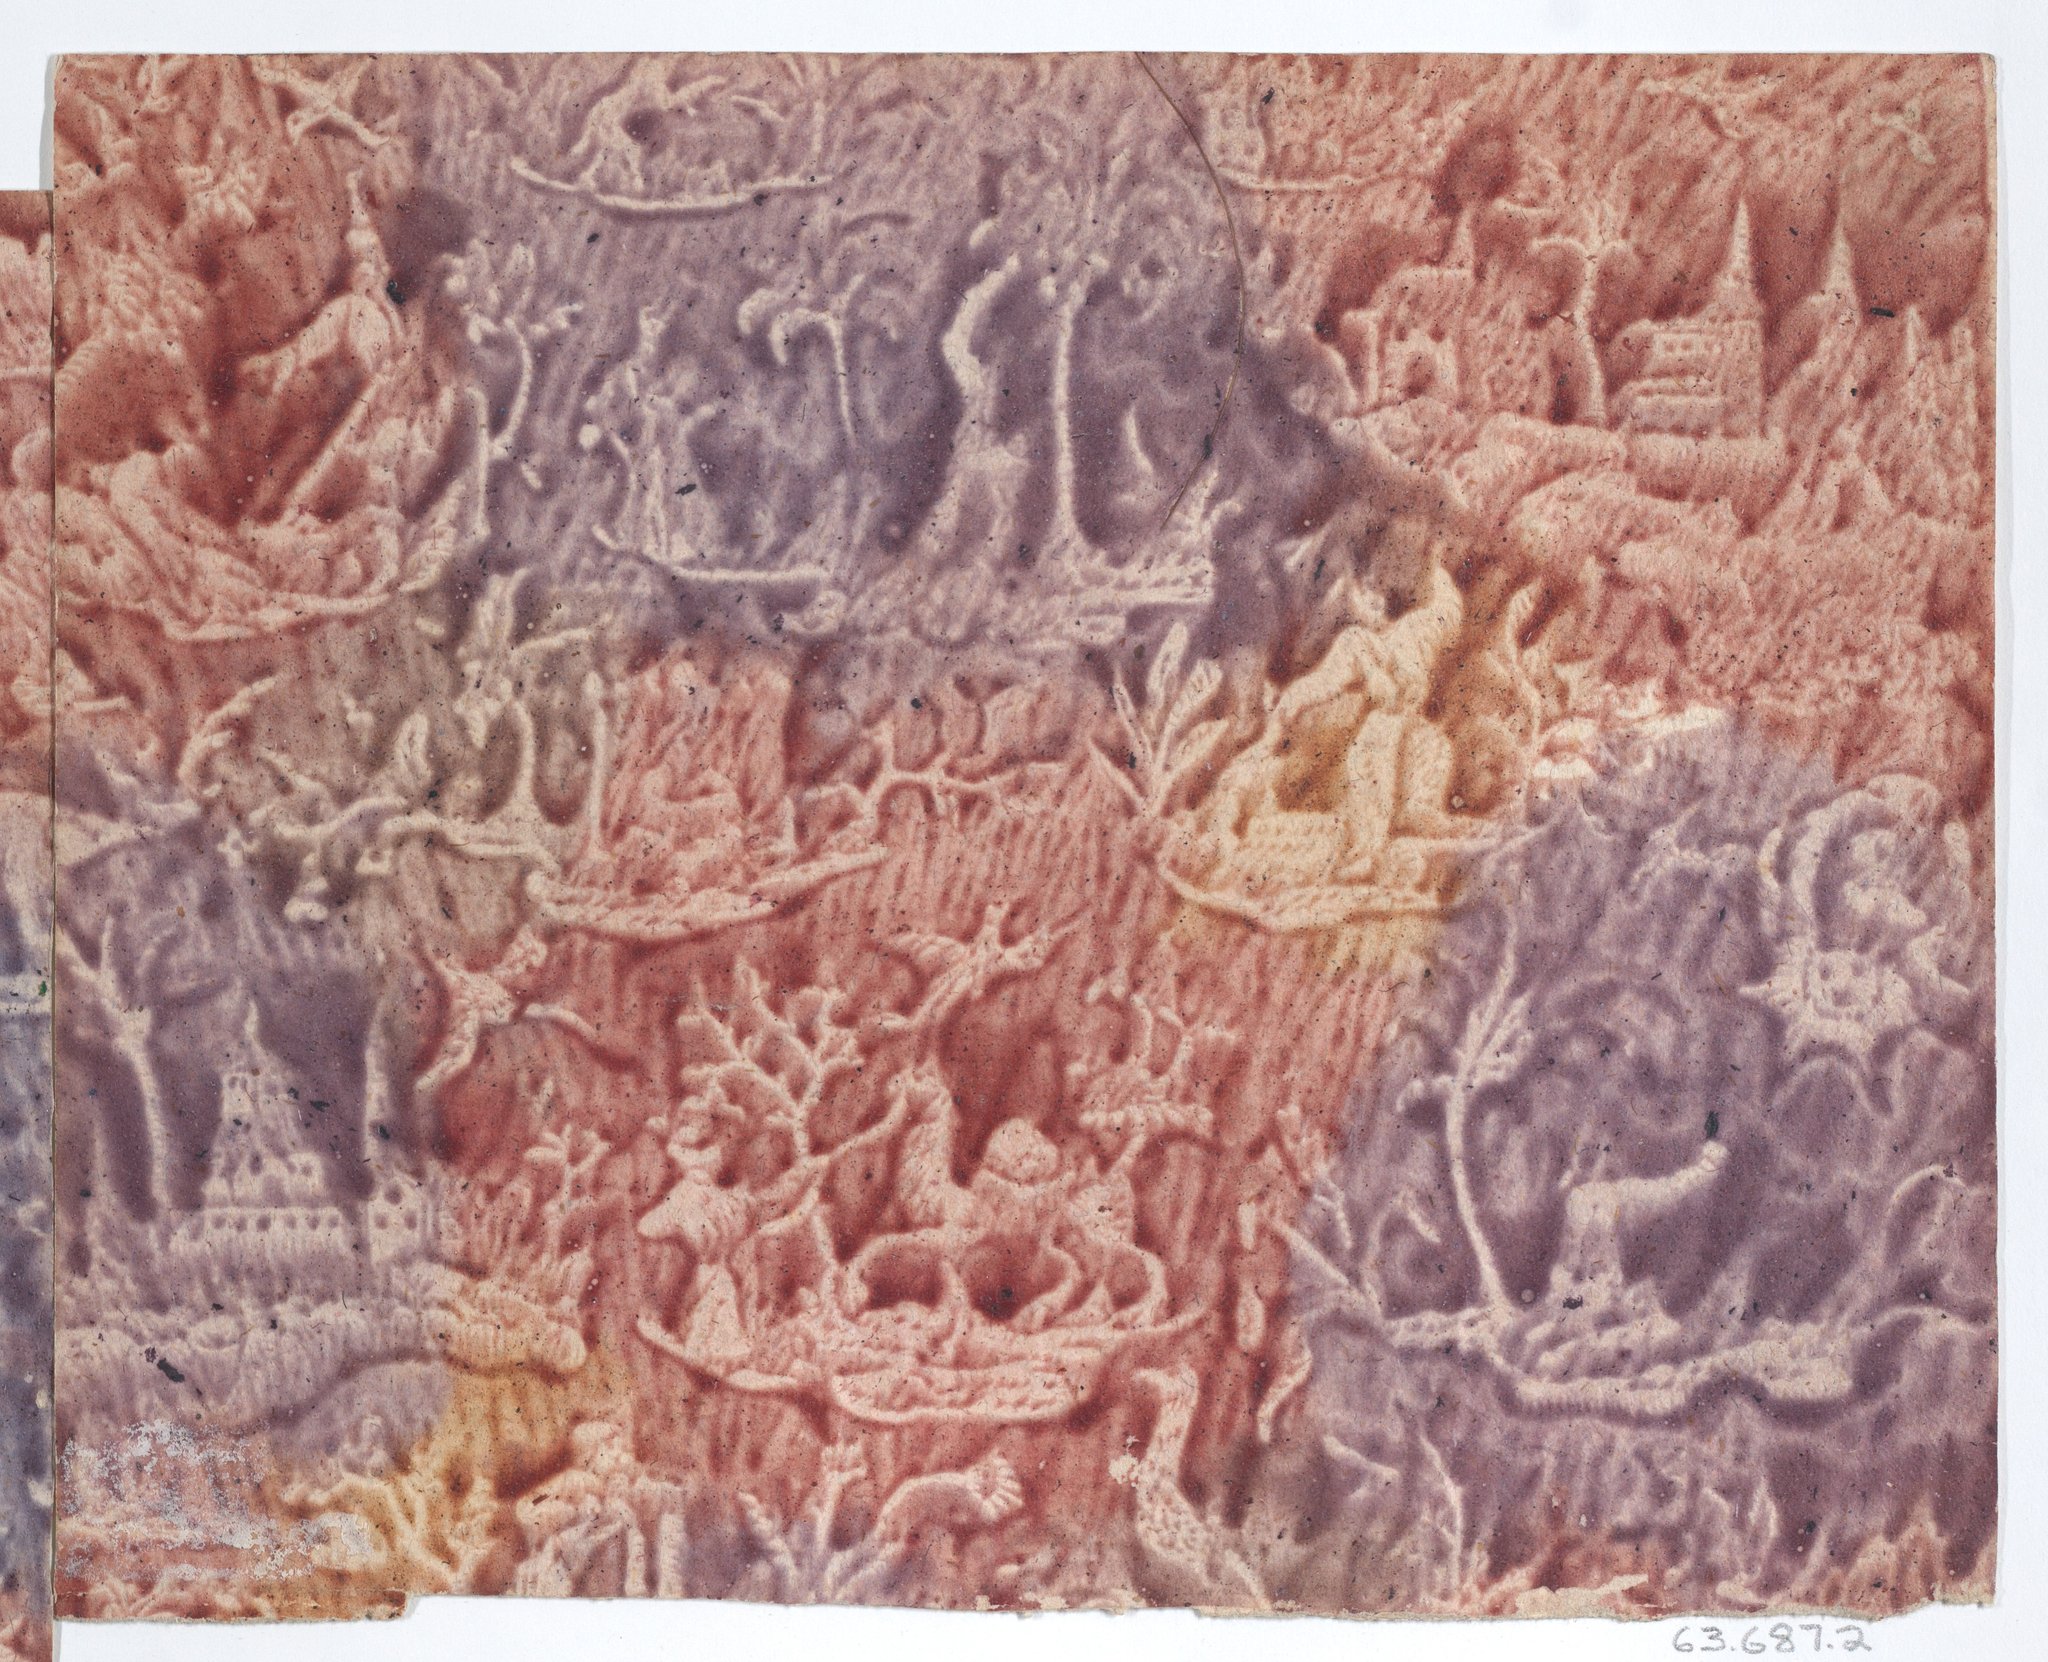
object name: print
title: Sheet with figures in landscapes in red, purple, and yellow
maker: Anonymous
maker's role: artist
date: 1701-1800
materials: paper, paste